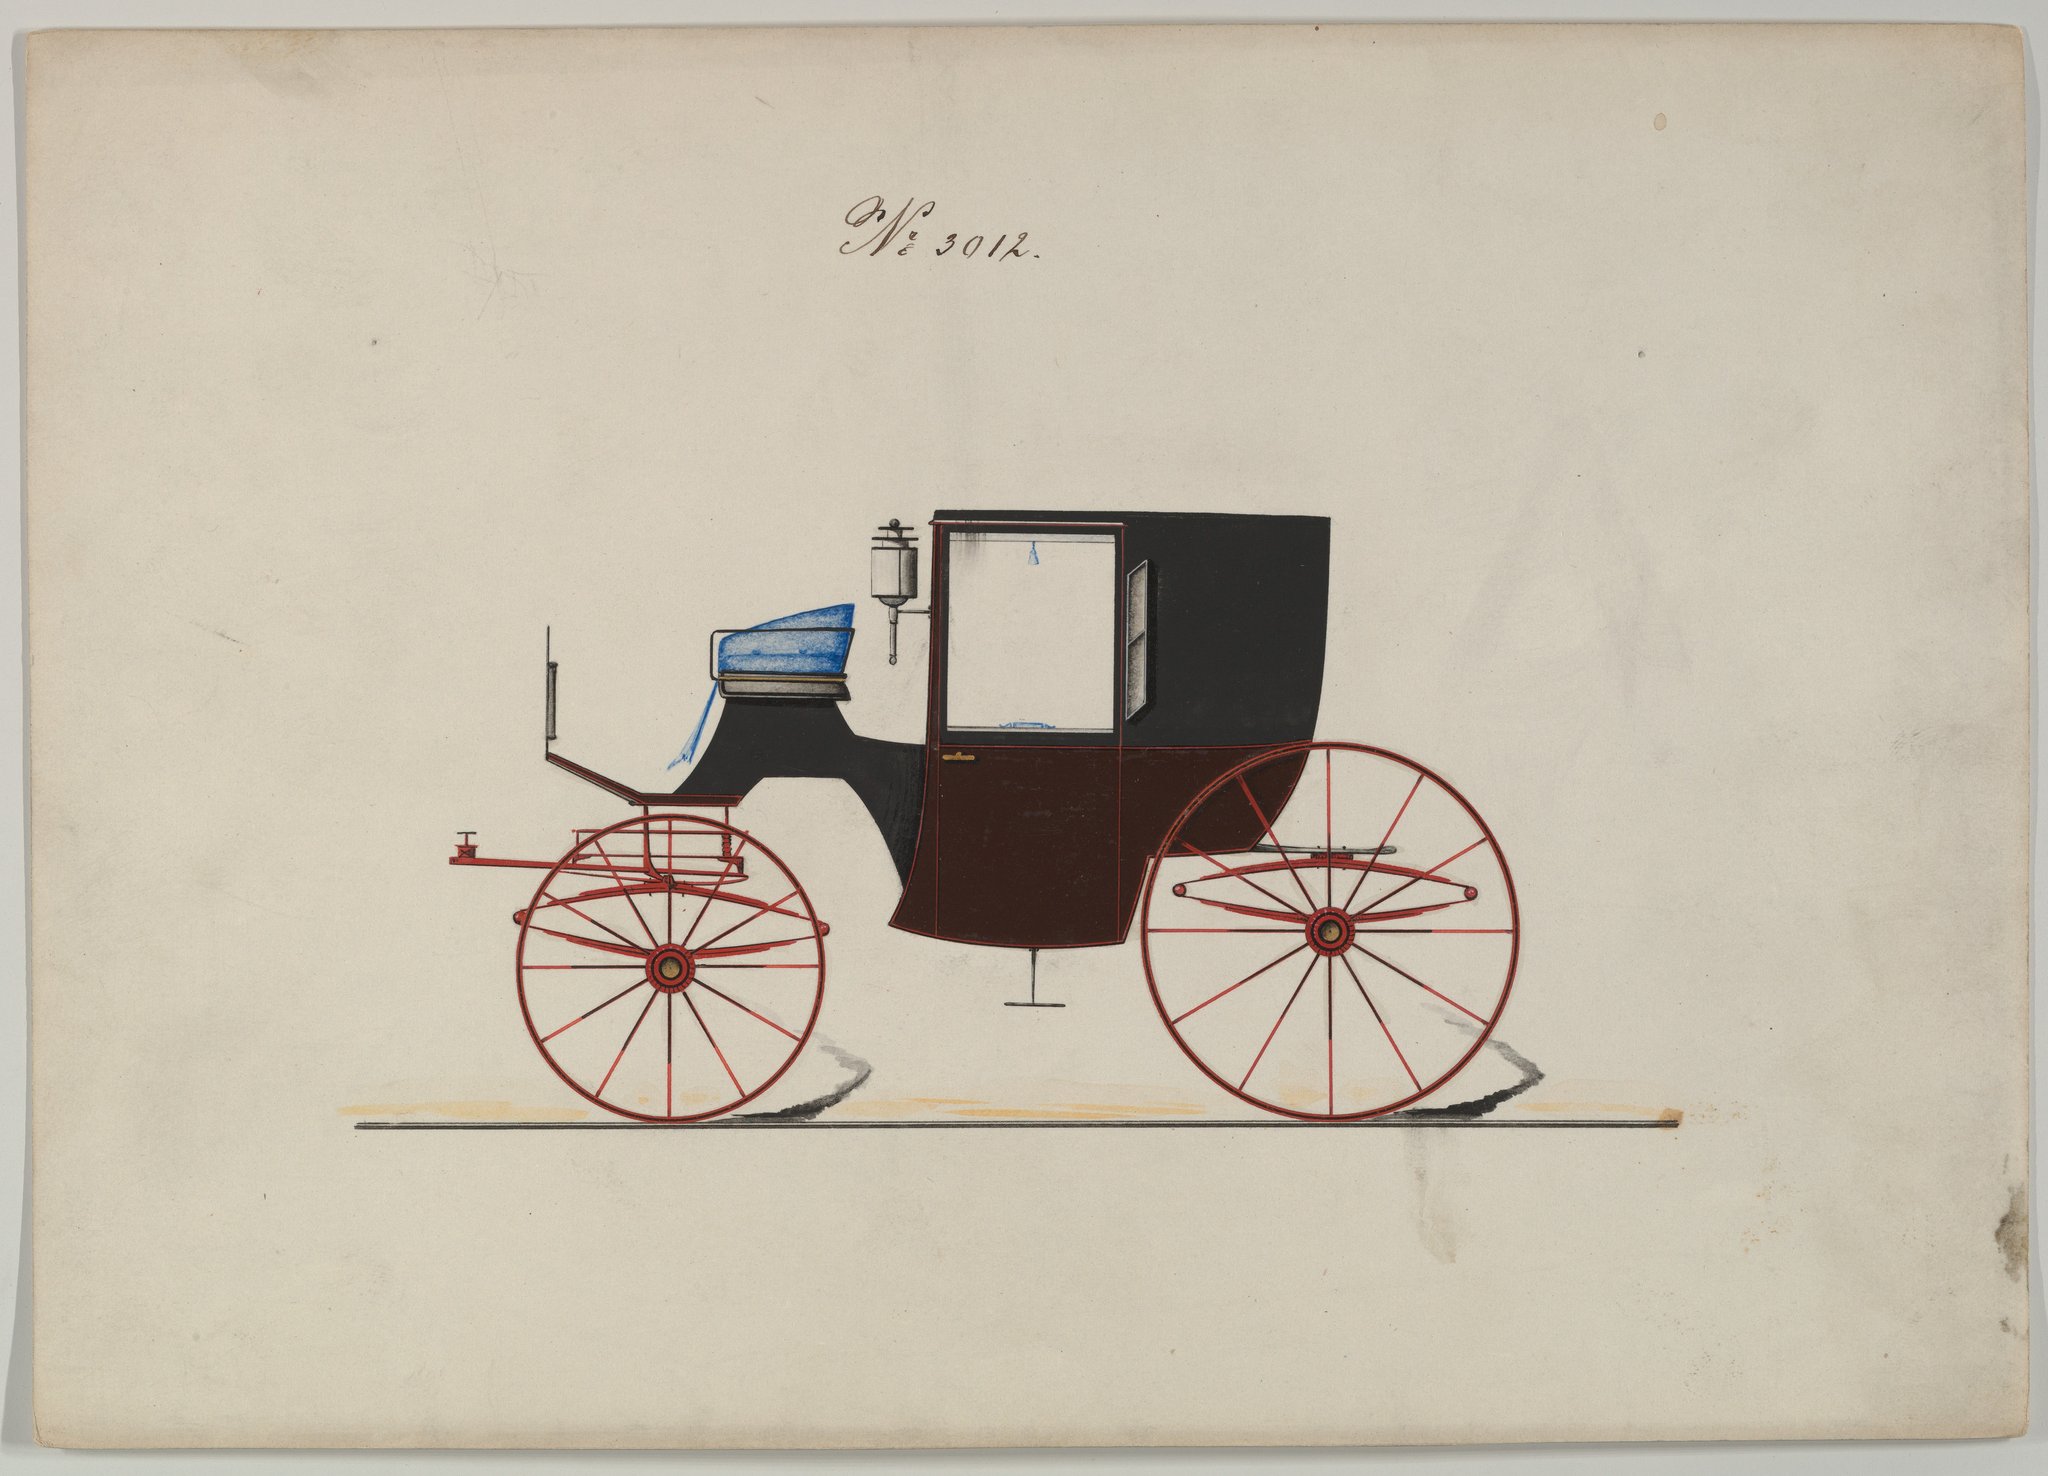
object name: drawing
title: Brougham #3012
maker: brewster & co.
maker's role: manufacturer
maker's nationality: american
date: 1874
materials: gouache, gum arabic, ink, watercolor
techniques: pen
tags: carriages